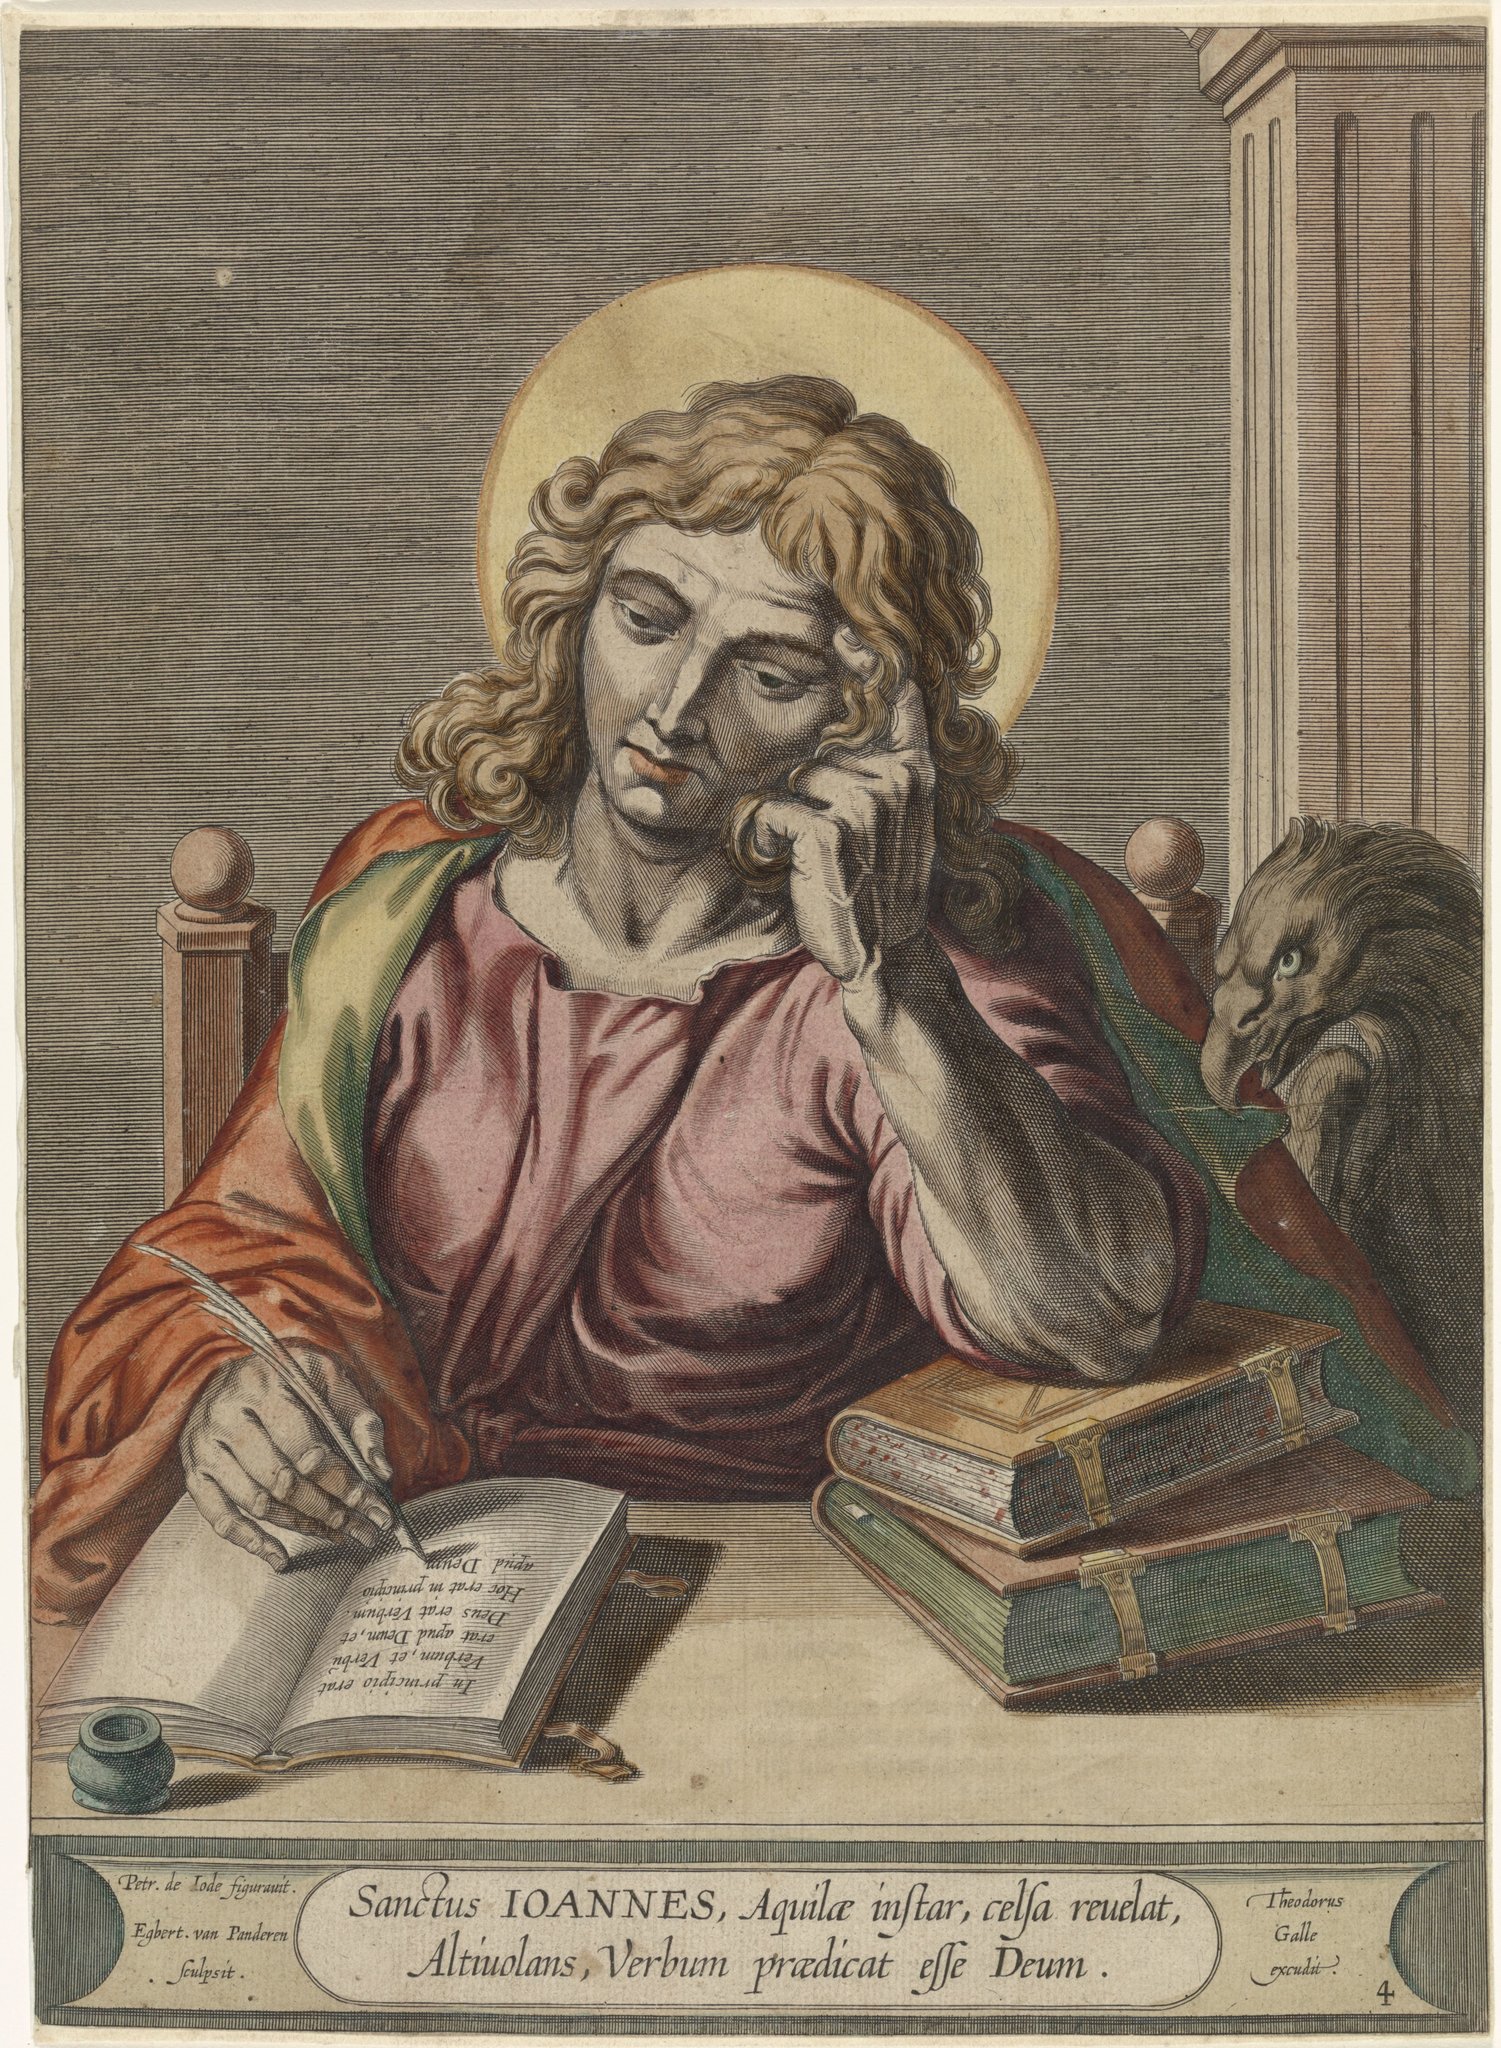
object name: print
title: Evangelist Johannes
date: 1590-1637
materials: paper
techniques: engraving, hand coloring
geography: antwerp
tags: st. john the evangelist writing the gospel, usually the eagle present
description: De evangelist Johannes, schrijvend aan een tafel. Met zijn linkerelleboog leunt hij op twee boeken. Naast hem zijn attribuut de adelaar. In een kader een tweeregelig onderschrift in het Latijn. Vierde prent uit een serie van vier met de evangelisten.